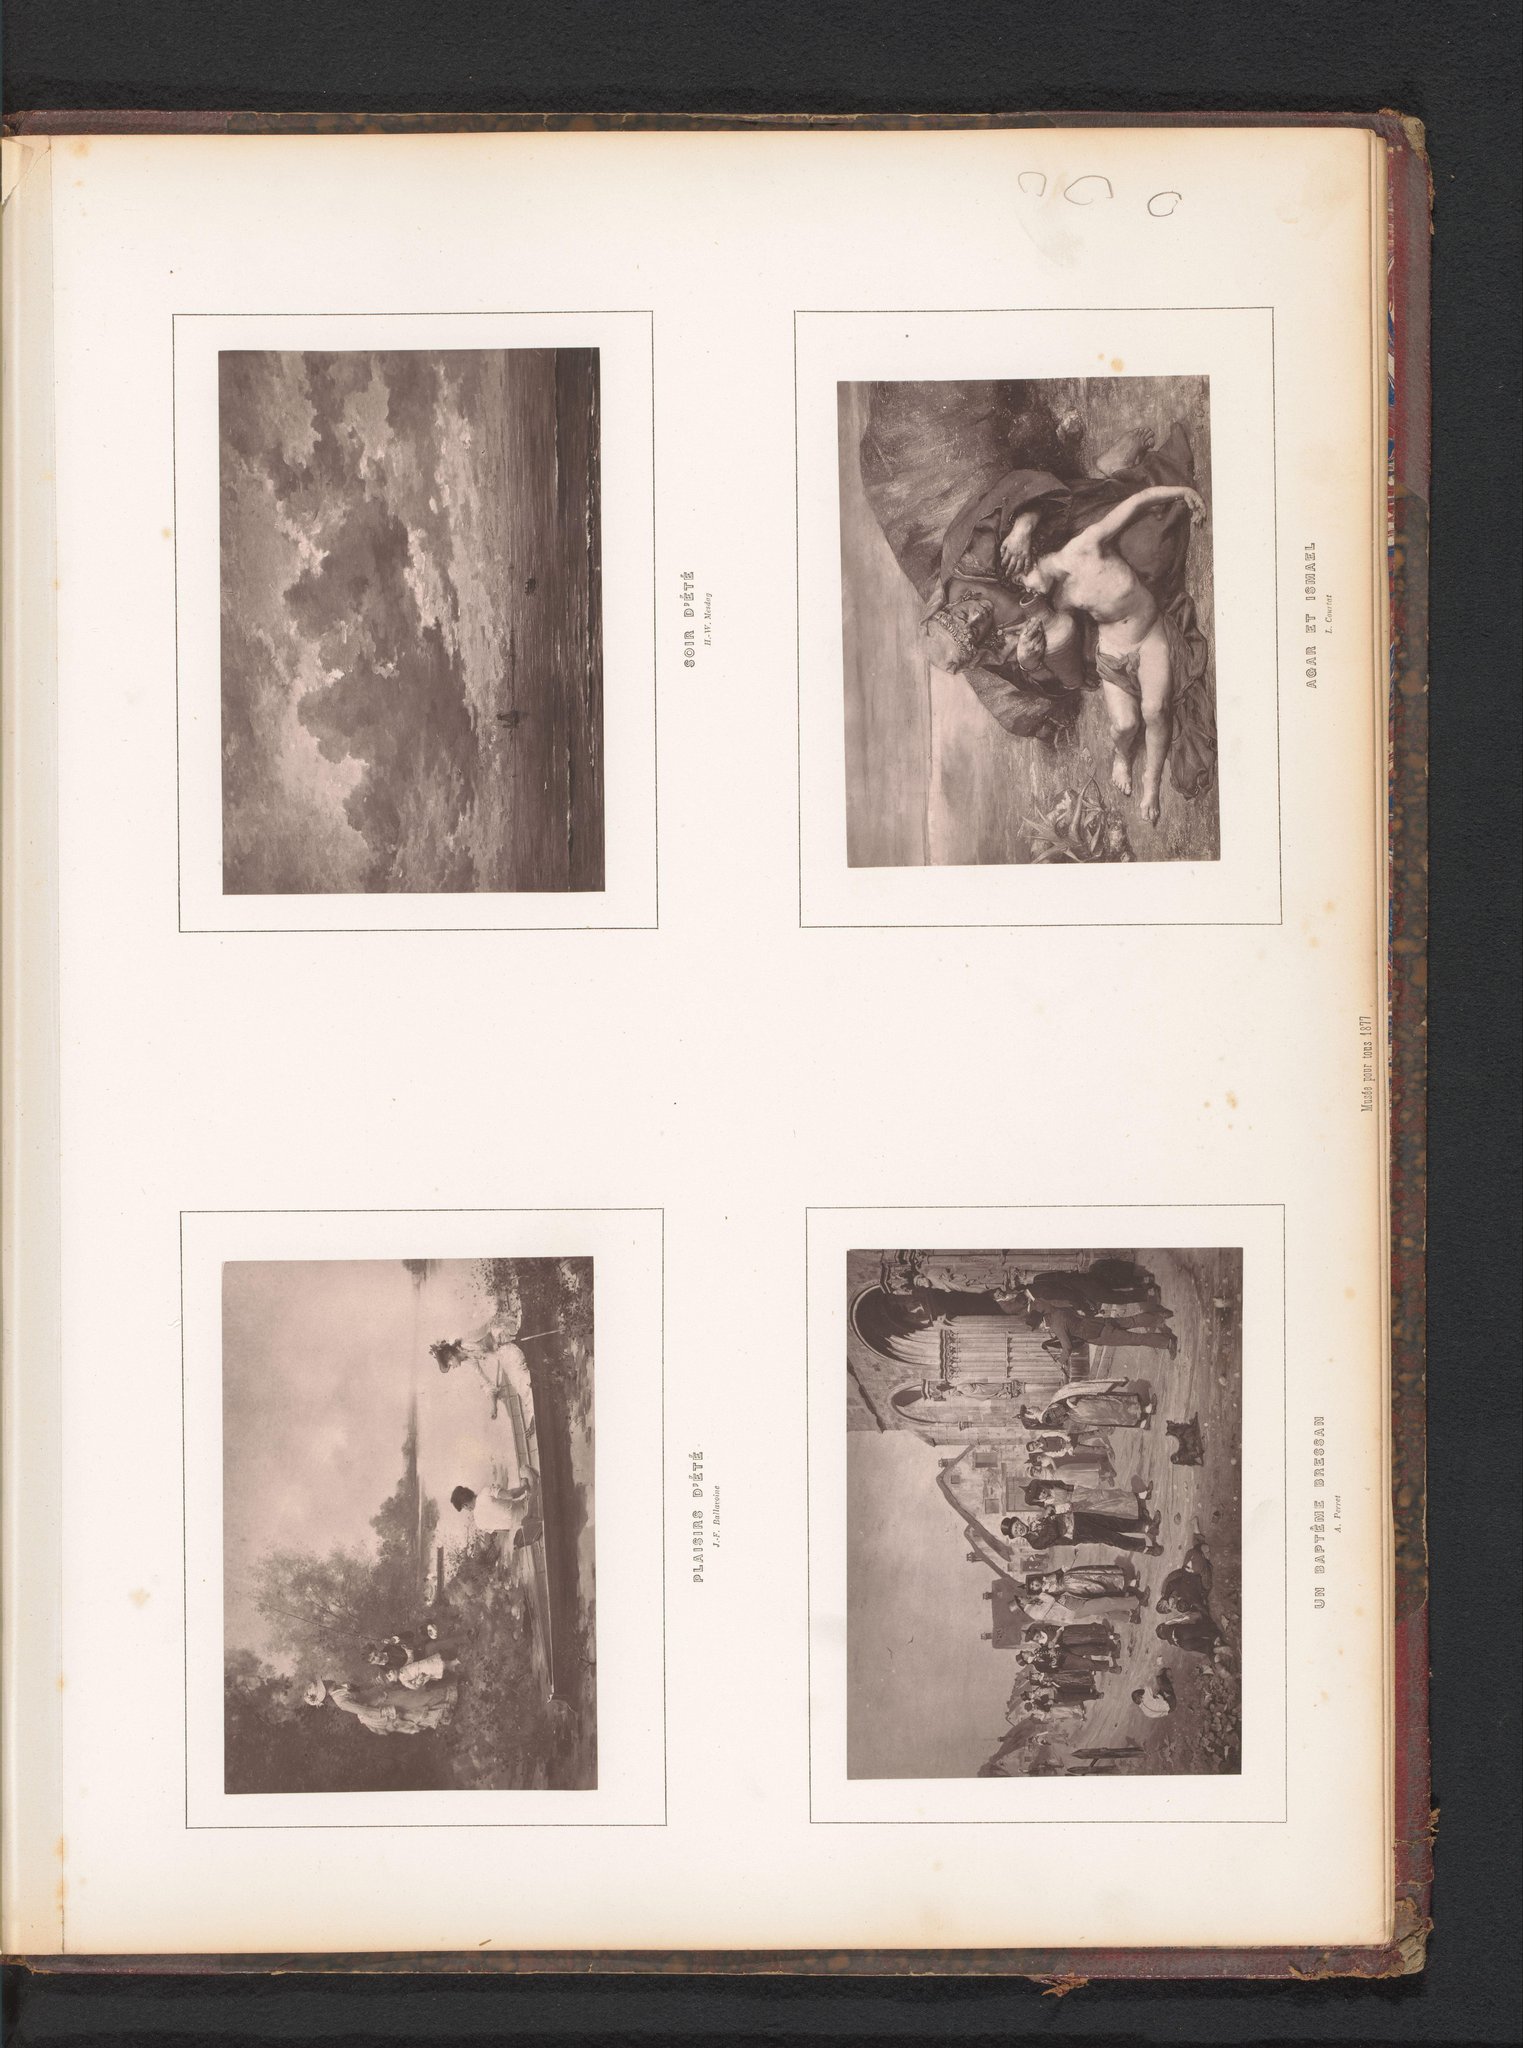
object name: page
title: Un baptême bressan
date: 1872-1879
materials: paper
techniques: woodburytype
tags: sea (seascape), open-air recreation, hagar and ishmael in the wilderness, baptism, christening ceremony ~ the first of the seven sacraments - qq - baptism in the open air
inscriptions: inscription: ‘Musée pour tous 1877’